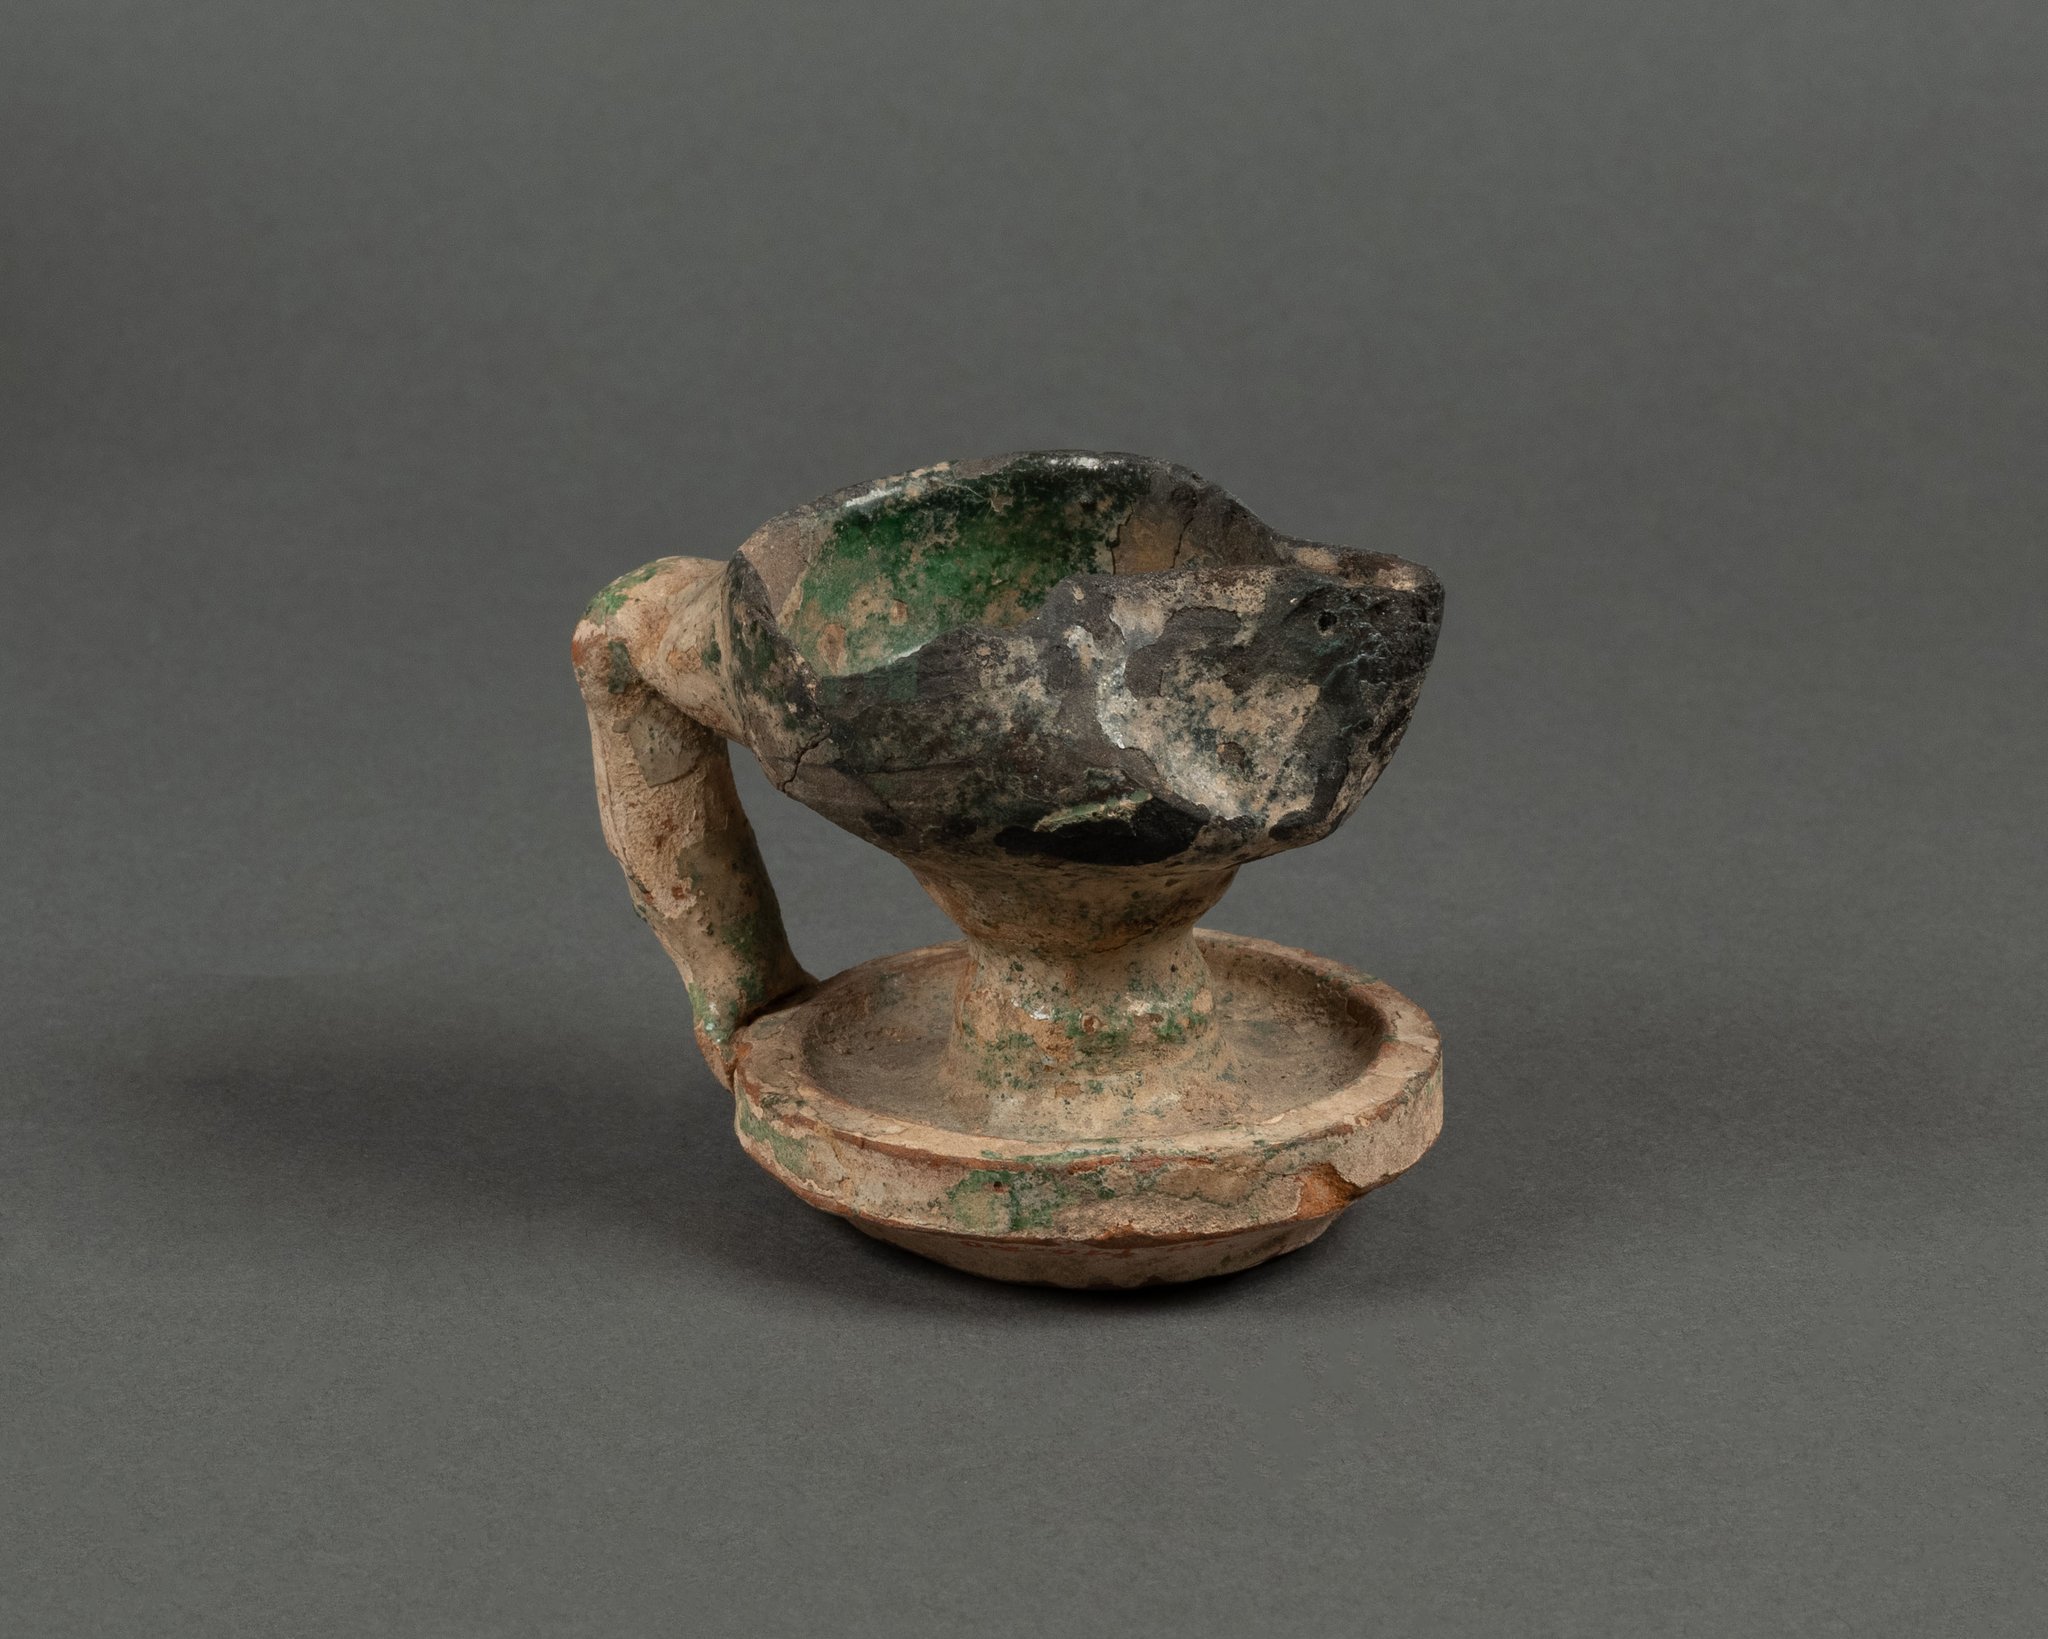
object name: lamp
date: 801-1000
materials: earthenware, glaze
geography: iran